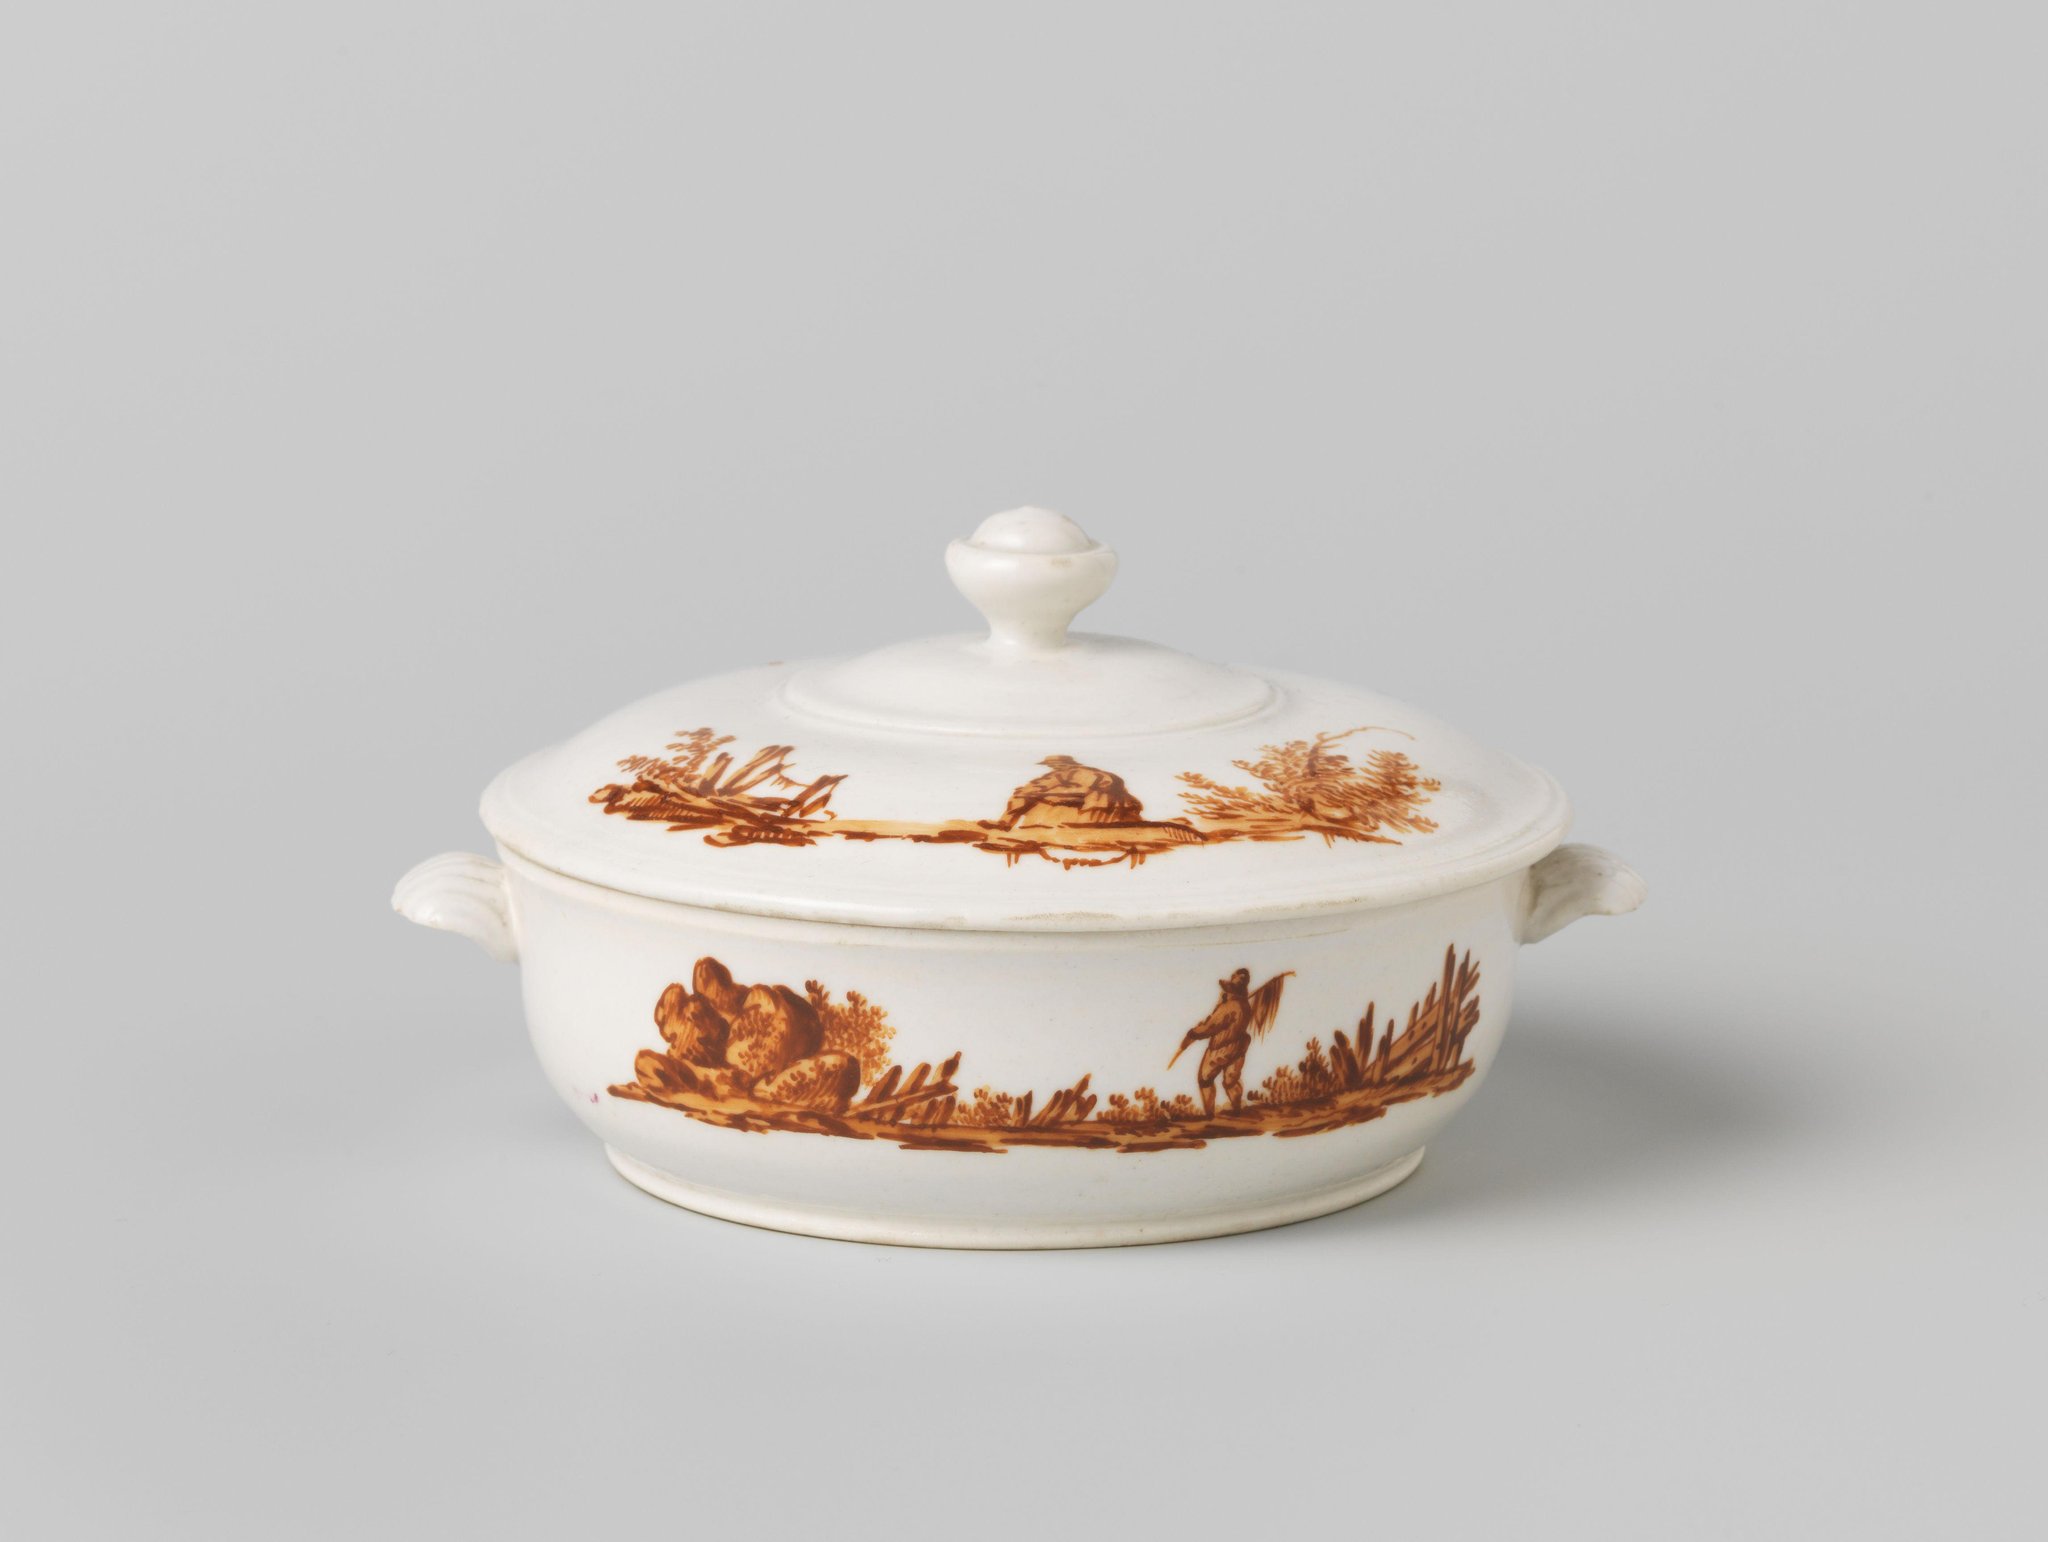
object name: butter dish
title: Botervloot, beschilderd met landschappen met figuren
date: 1774-1778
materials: porcelain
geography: loosdrecht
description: Two butter dishes. Porcelain. Loosdrecht, c. 1774 - 1778. Factory of Joannes de Mol.